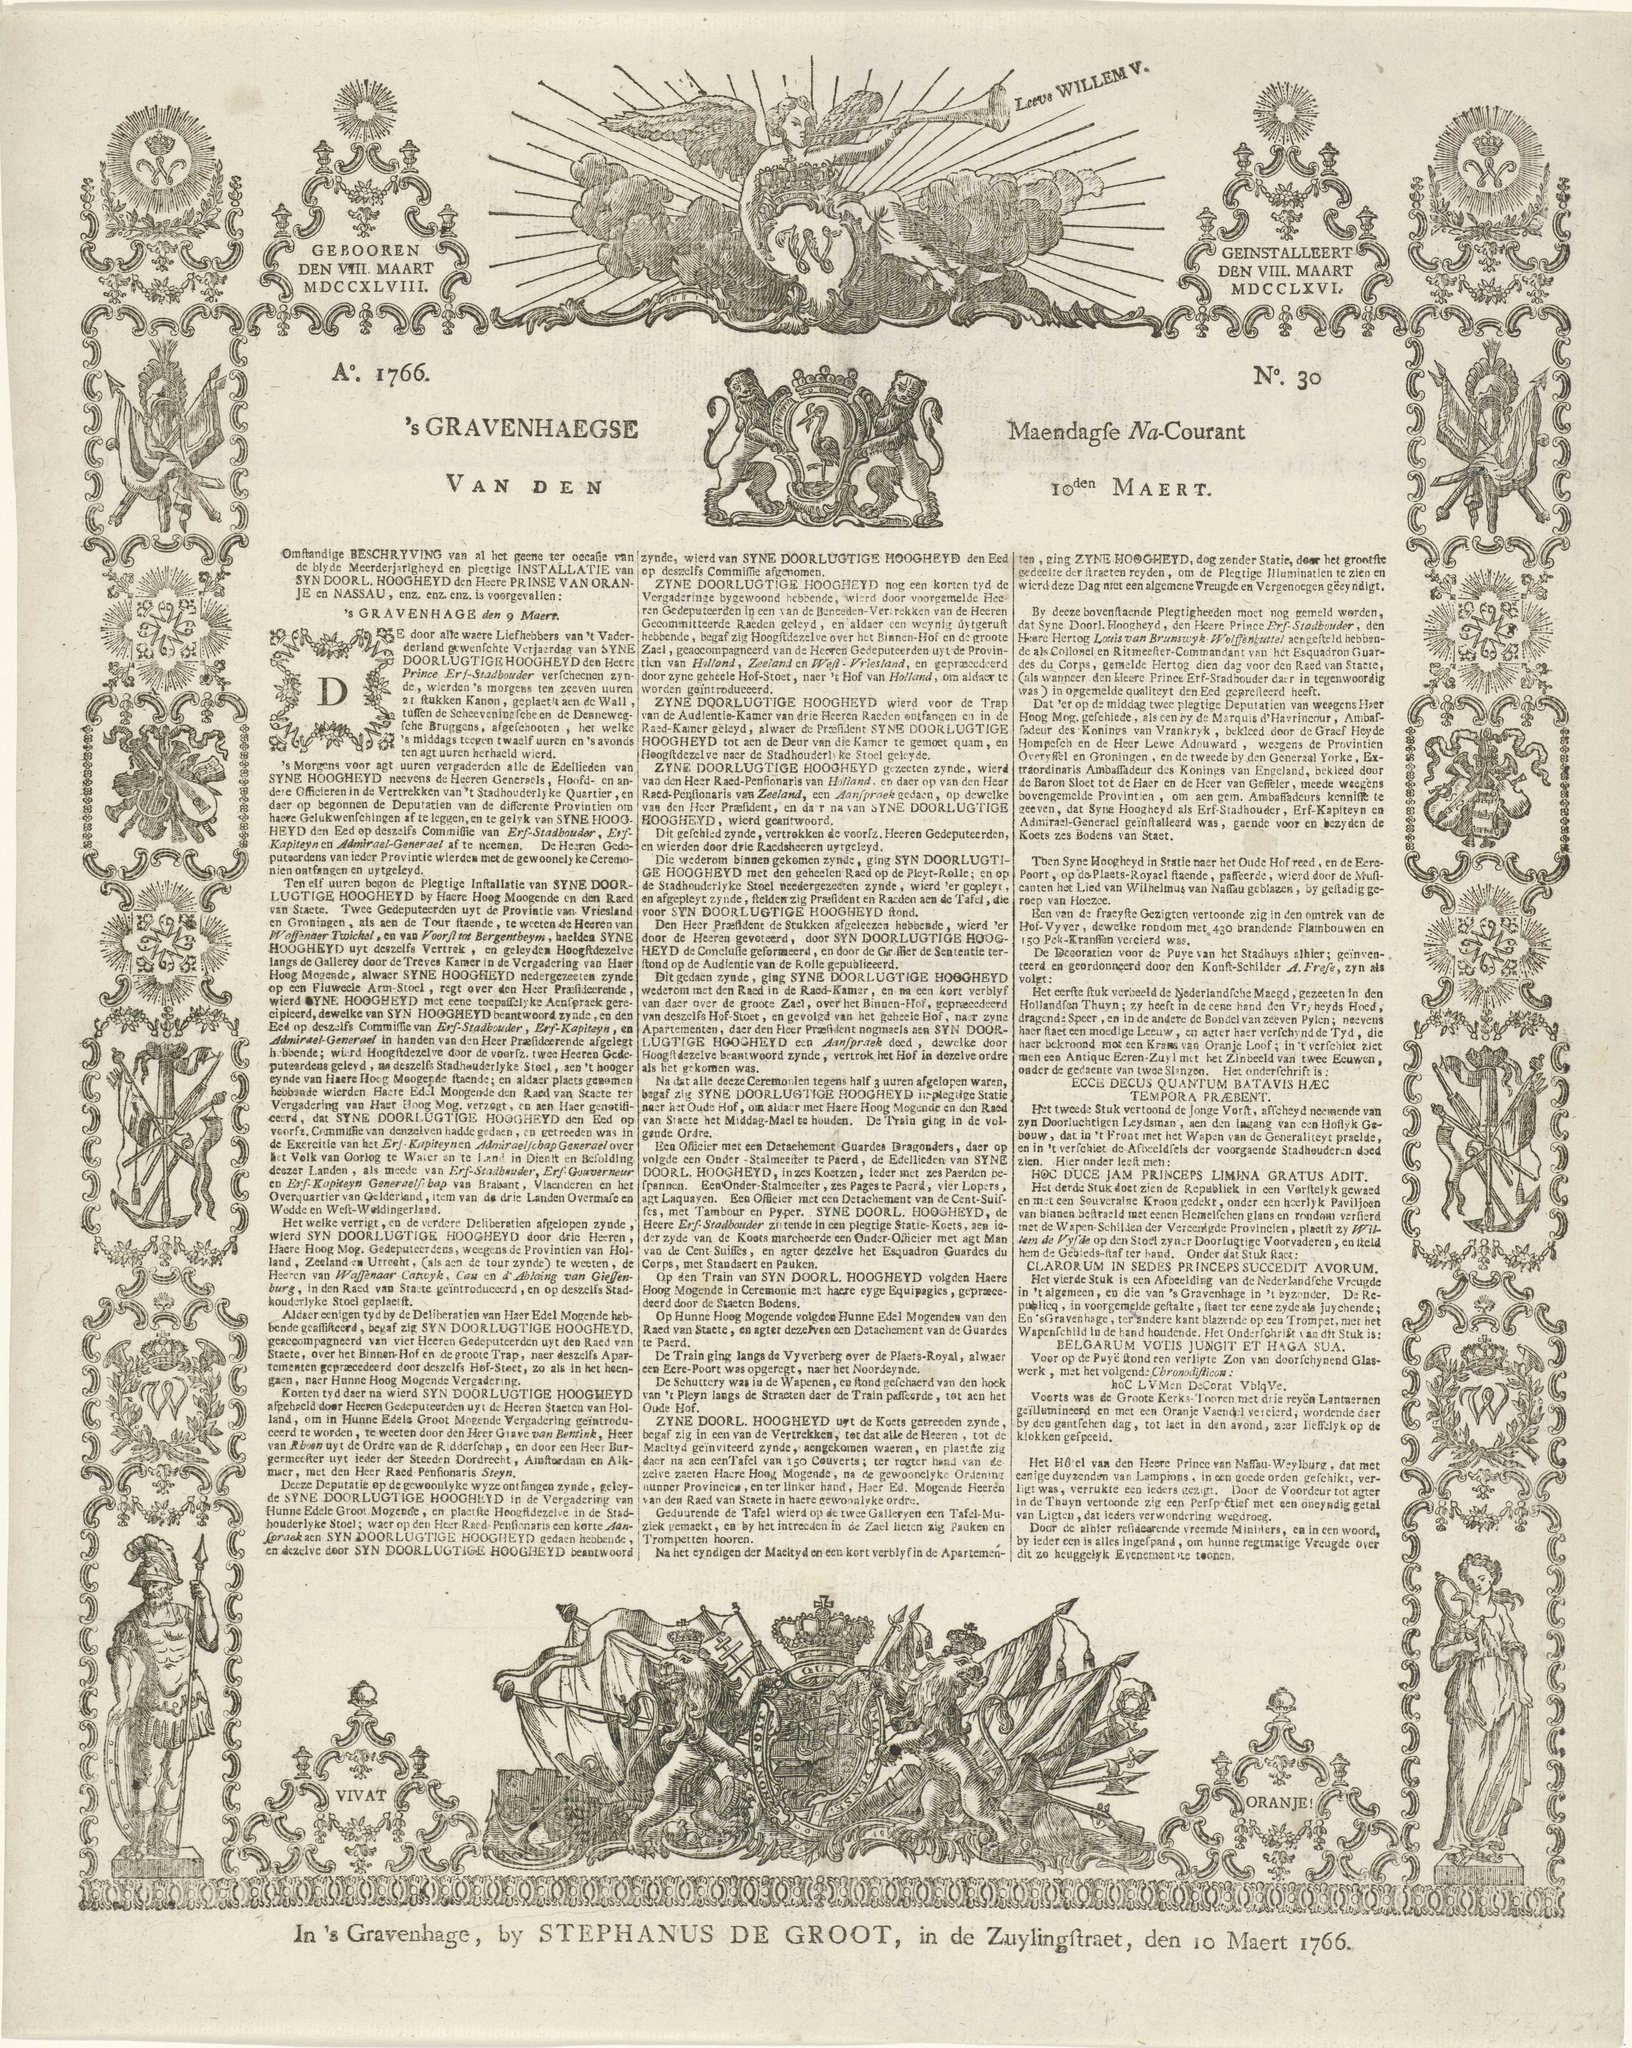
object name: newspaper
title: 's Gravenhaegse Maendagse Na-Courant van den 10den Maert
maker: stephanus de groot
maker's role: publisher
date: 1766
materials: paper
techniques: letterpress printing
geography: the hague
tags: william v (prince of orange)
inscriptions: collector's mark: Lugt 2228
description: Aflevering van de 's Gravenhaegse Maendagse Na-Courant van 10 maart 1766 ter gelegenheid van de installatie van prins Willem V als erfstadhouder in de Staten-Generaal op 8 maart. Blad op één zijde bedrukt met een beschrijving van de gebeurtenissen. Binnen een ornamentele rand opgebouwd uit fileten en vignetten.